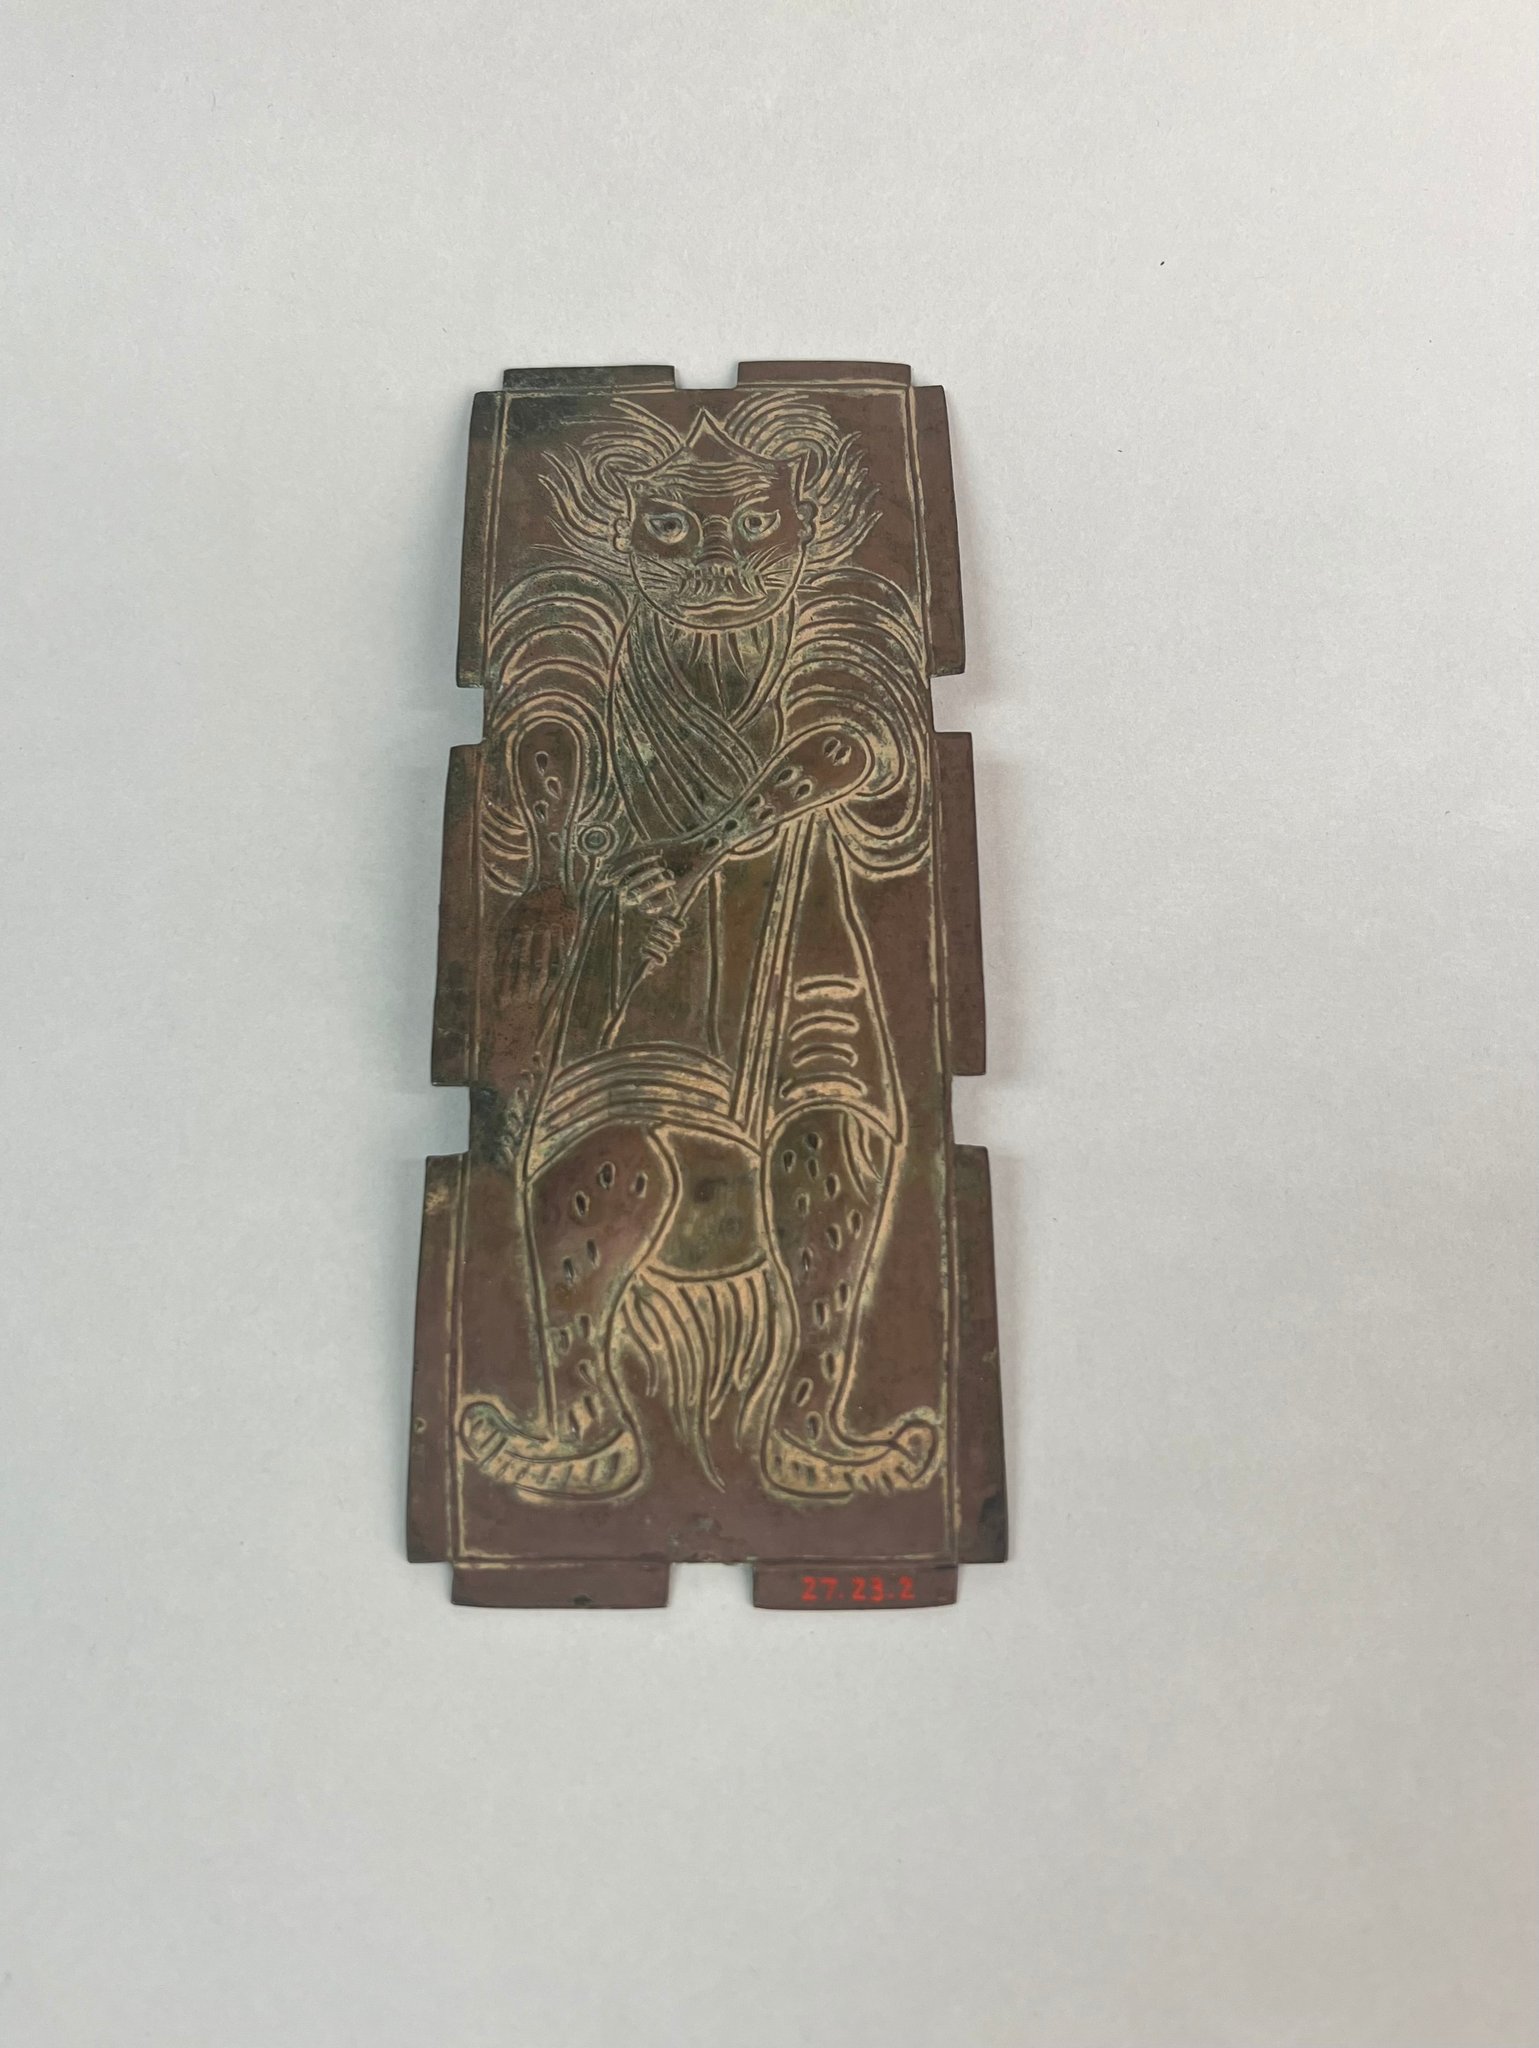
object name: plaque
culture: chinese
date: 206 BCE-220 CE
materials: pewter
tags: mythical creatures